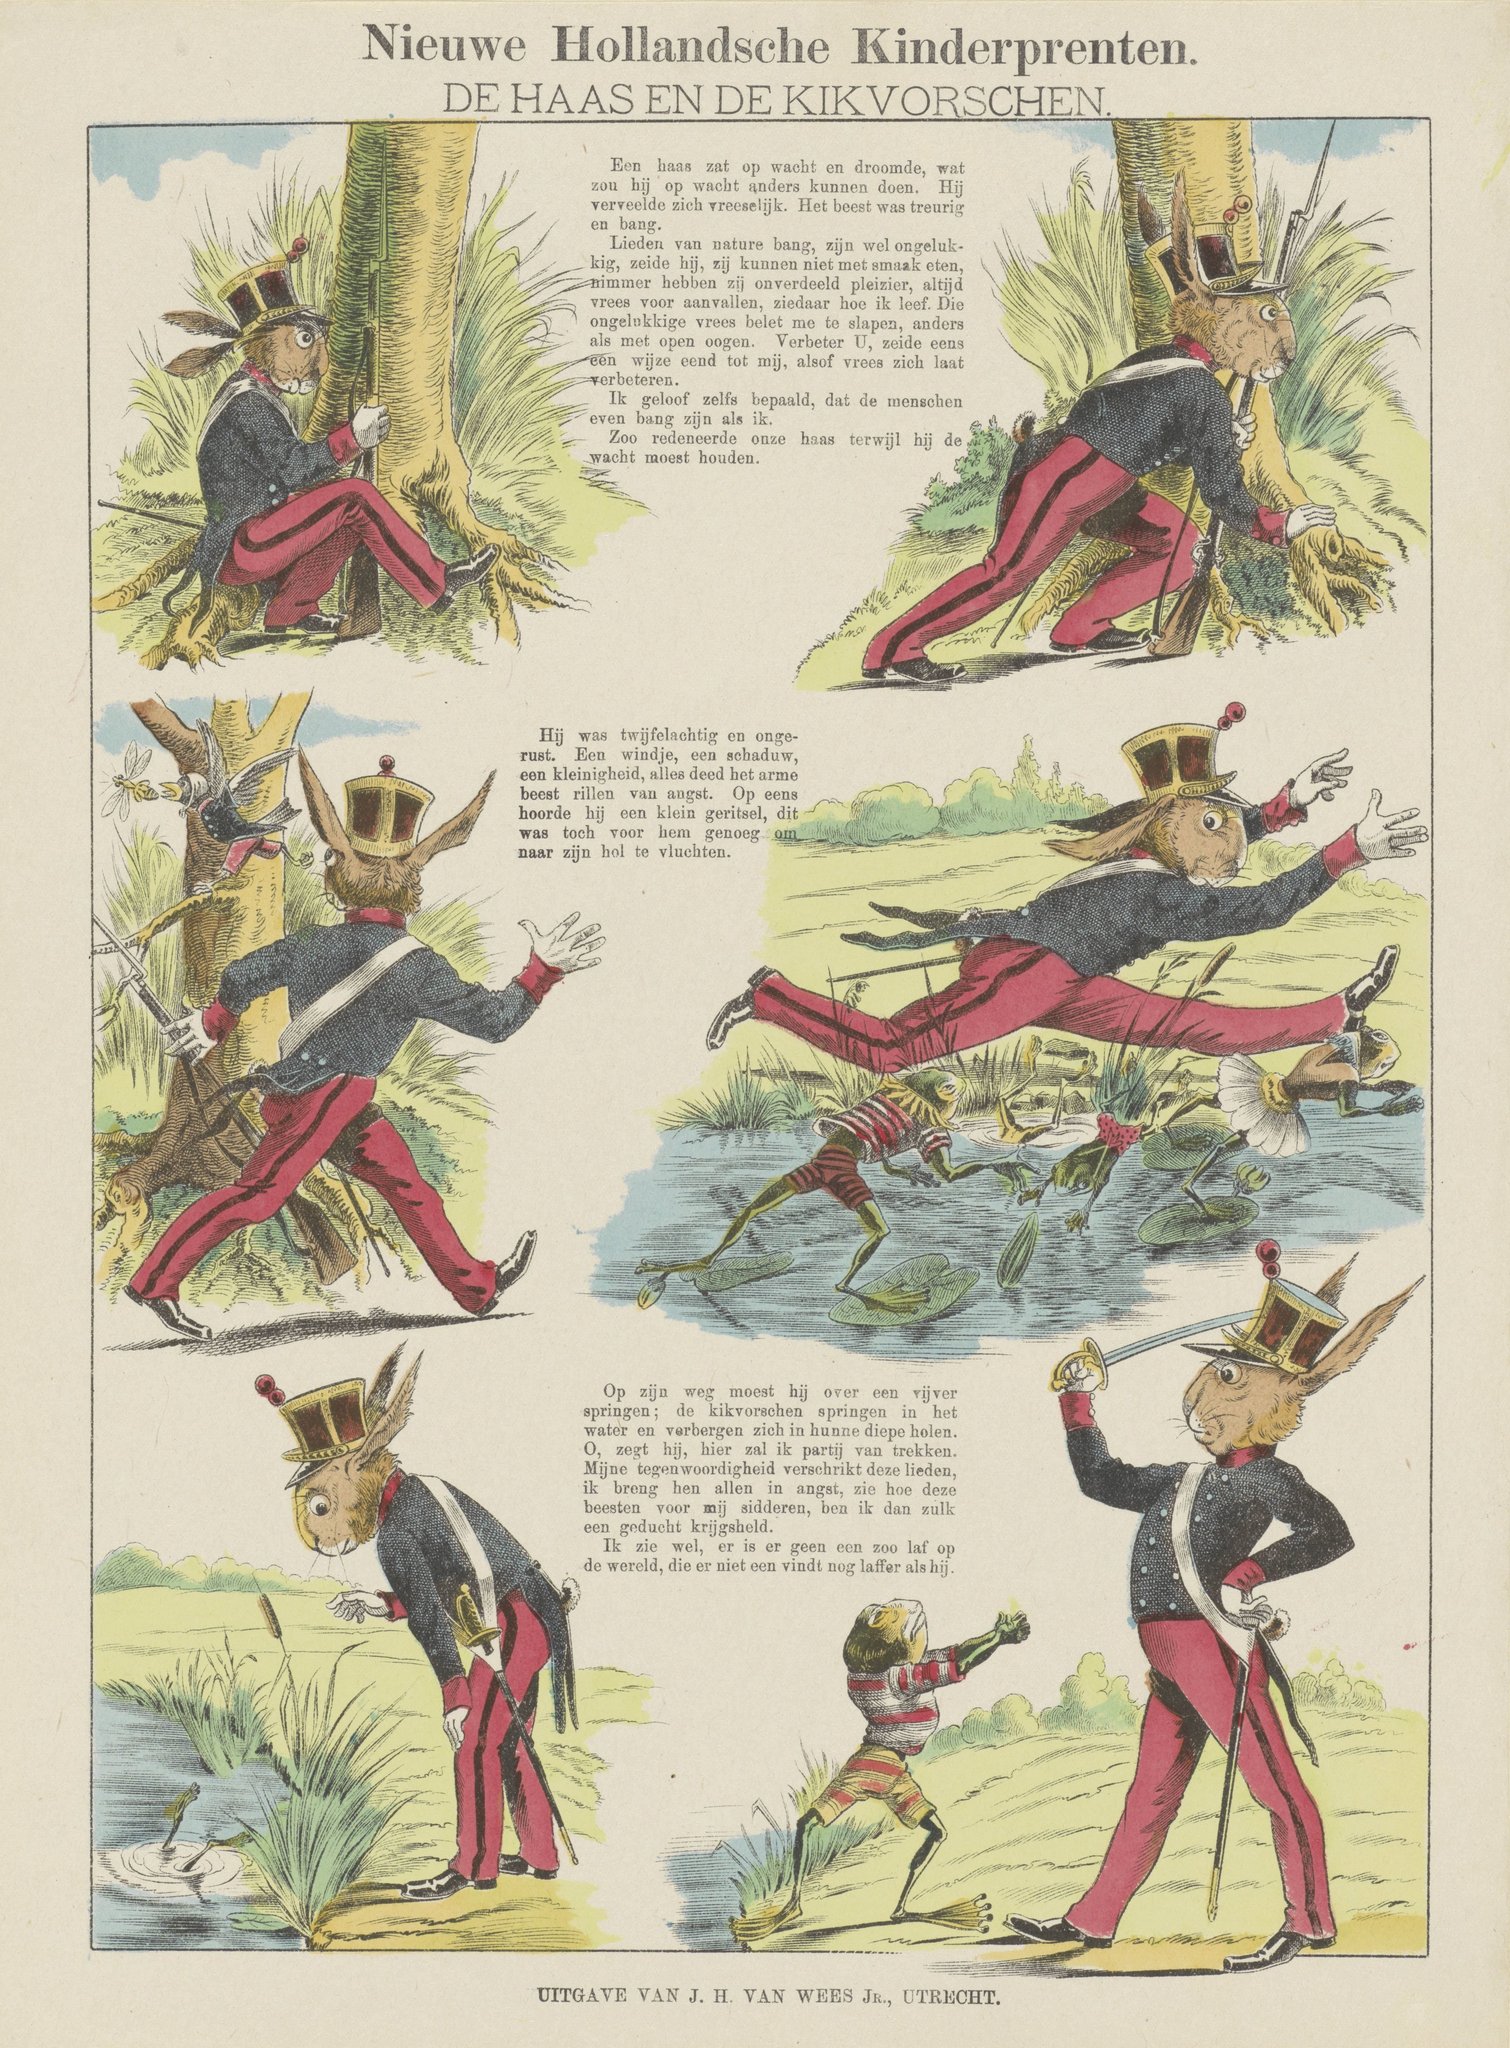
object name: popular print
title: De haas en de kikvorschen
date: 1869-1888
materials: paper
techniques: colour, letterpress printing, lithograph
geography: utrecht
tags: tailless amphibians: frog, animals acting as human beings, rodents: hare, fables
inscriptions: collector's mark: Lugt 2760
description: Nederlandse heruitgave door J.H. van Wees (II) van een origineel Franse prent uitgegeven door Charles Pinot.